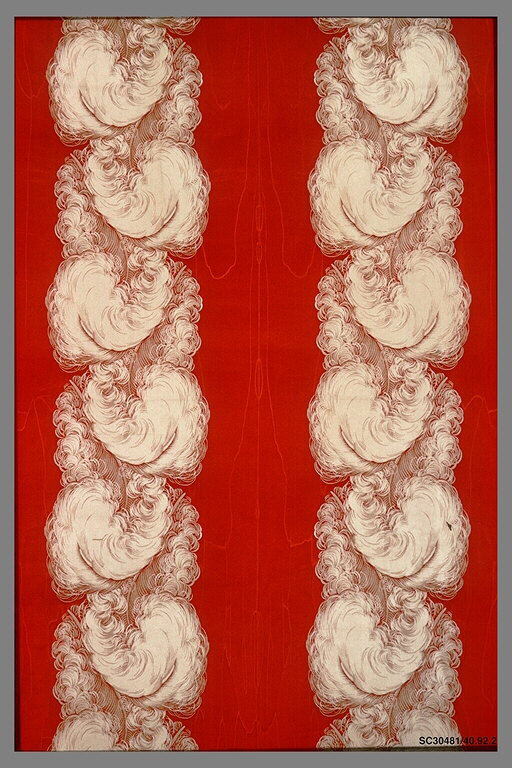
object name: piece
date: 1867-1900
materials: silk